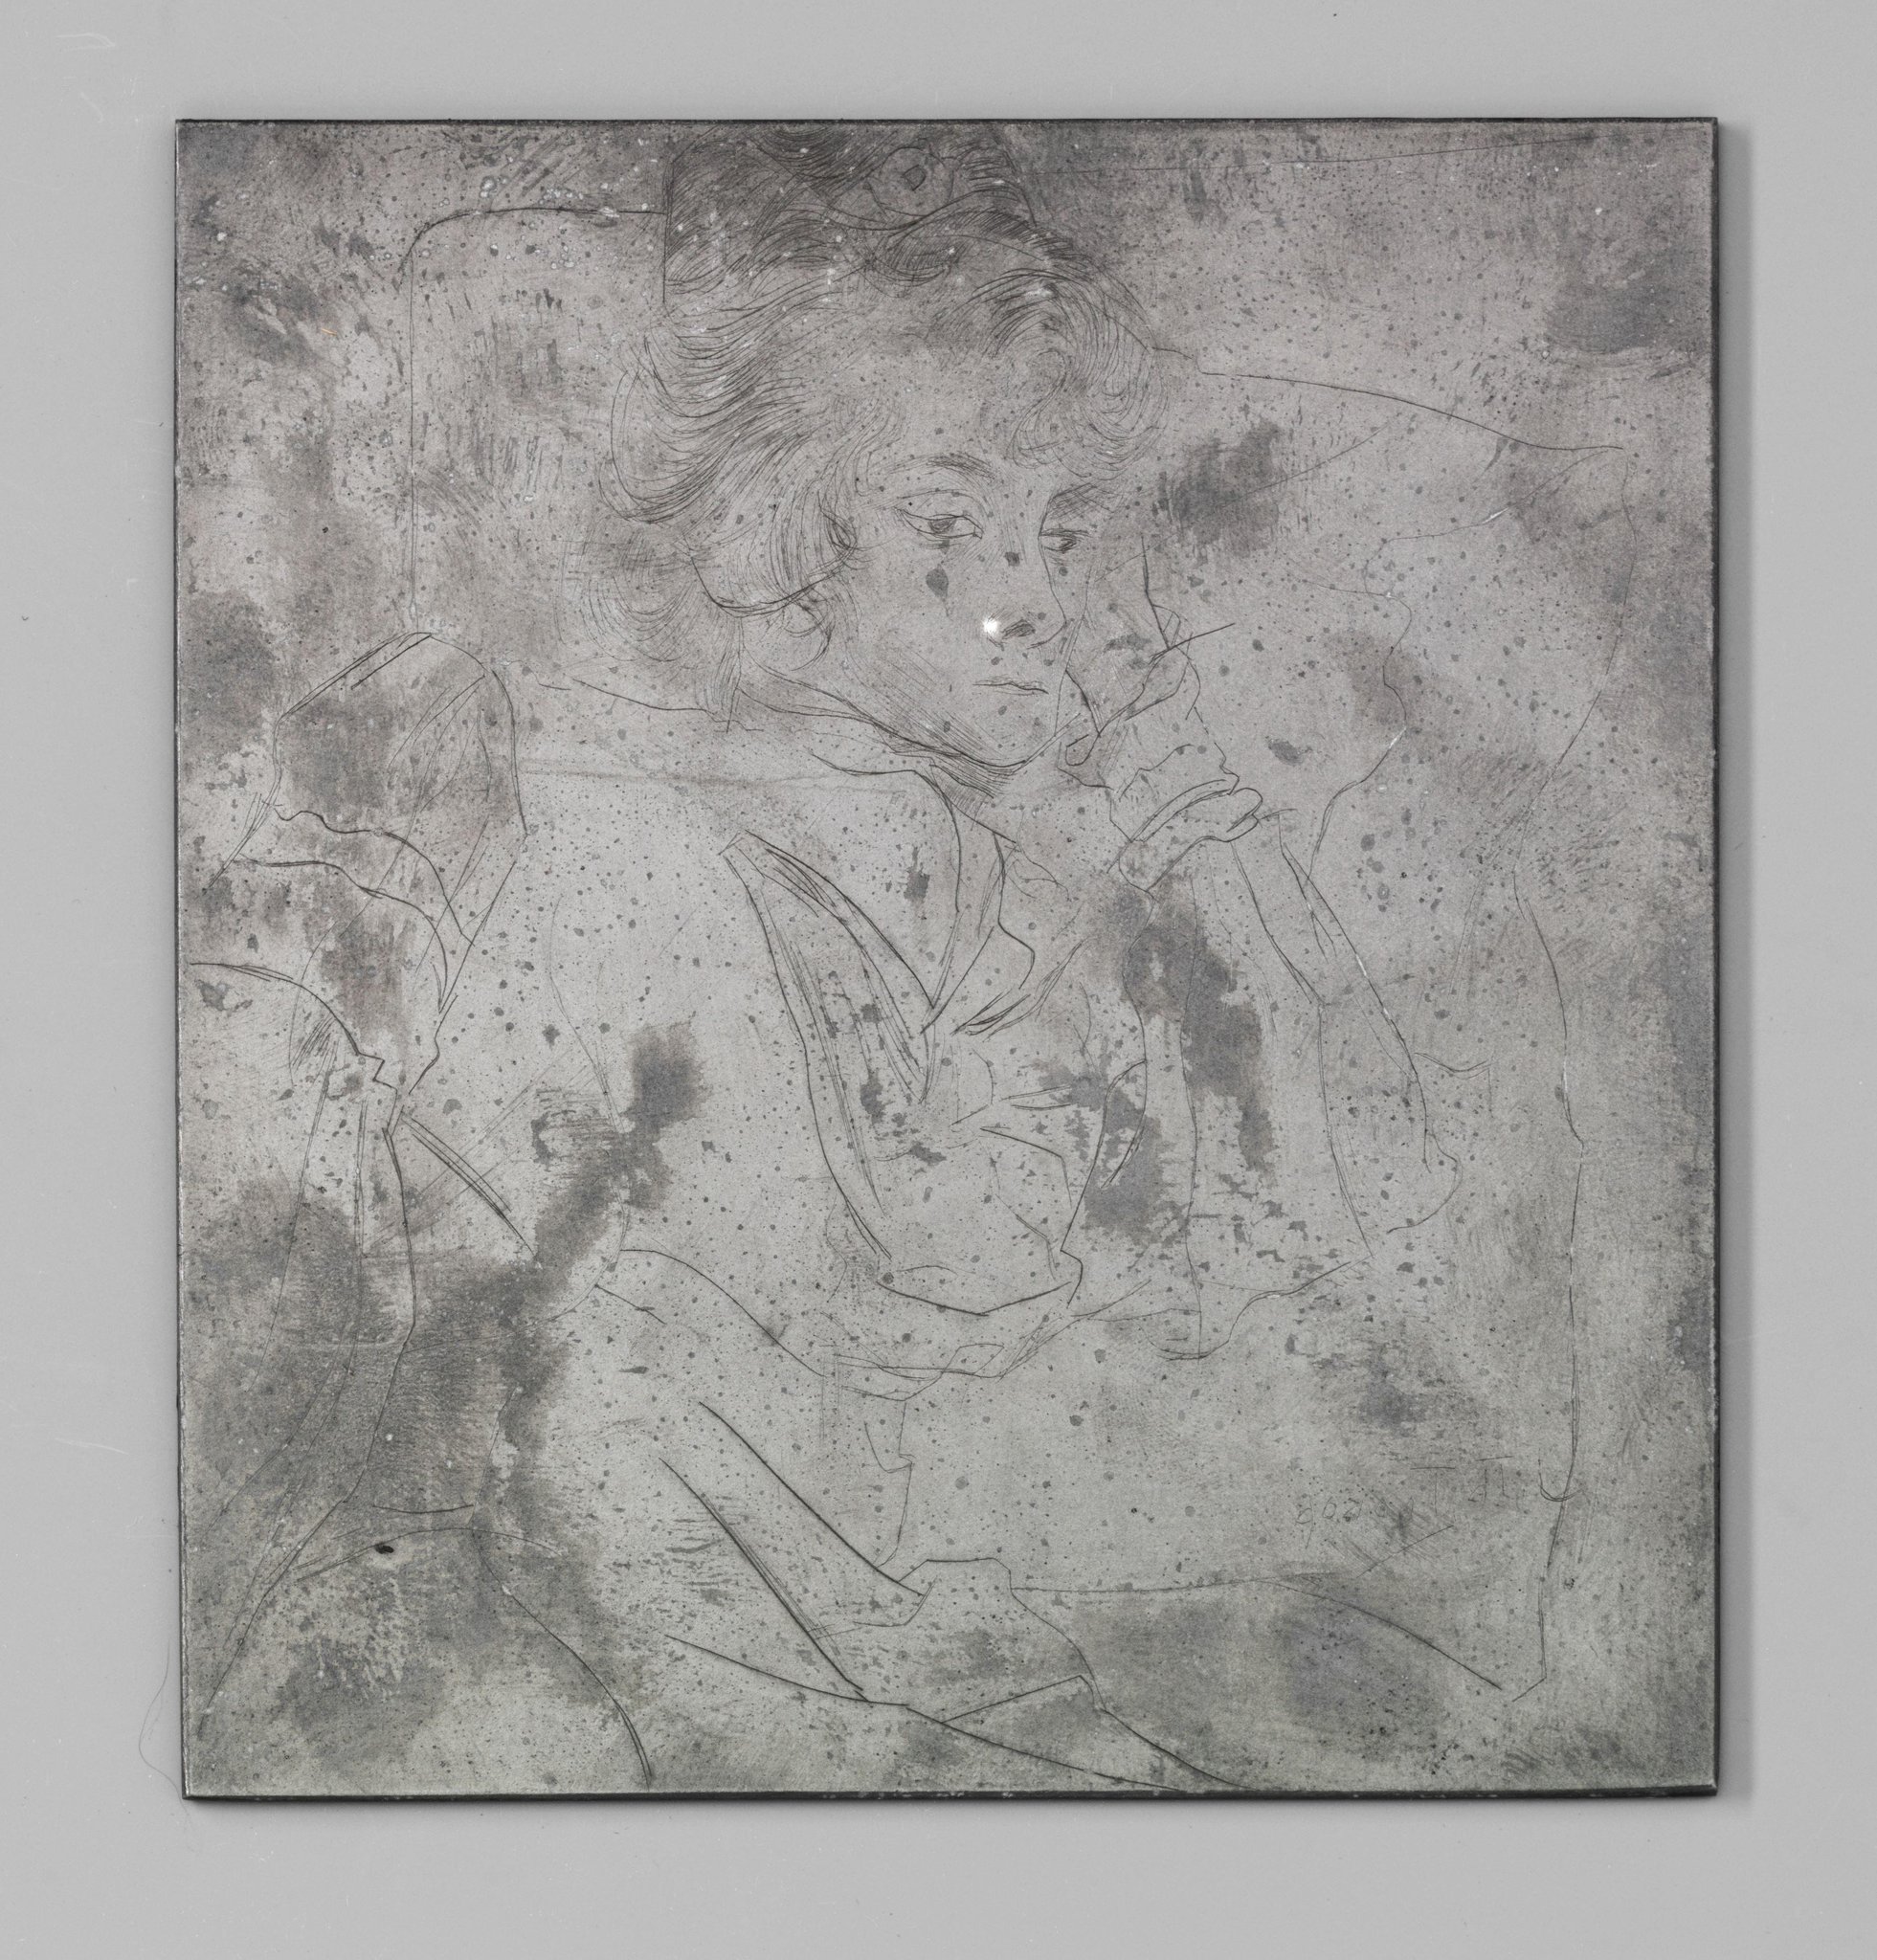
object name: zinkplaat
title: Jonge vrouw leunend tegen een kussen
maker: jan toorop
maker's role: draughtsman, painter, print maker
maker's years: 1858-1928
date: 1875-1928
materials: zinc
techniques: drypoint